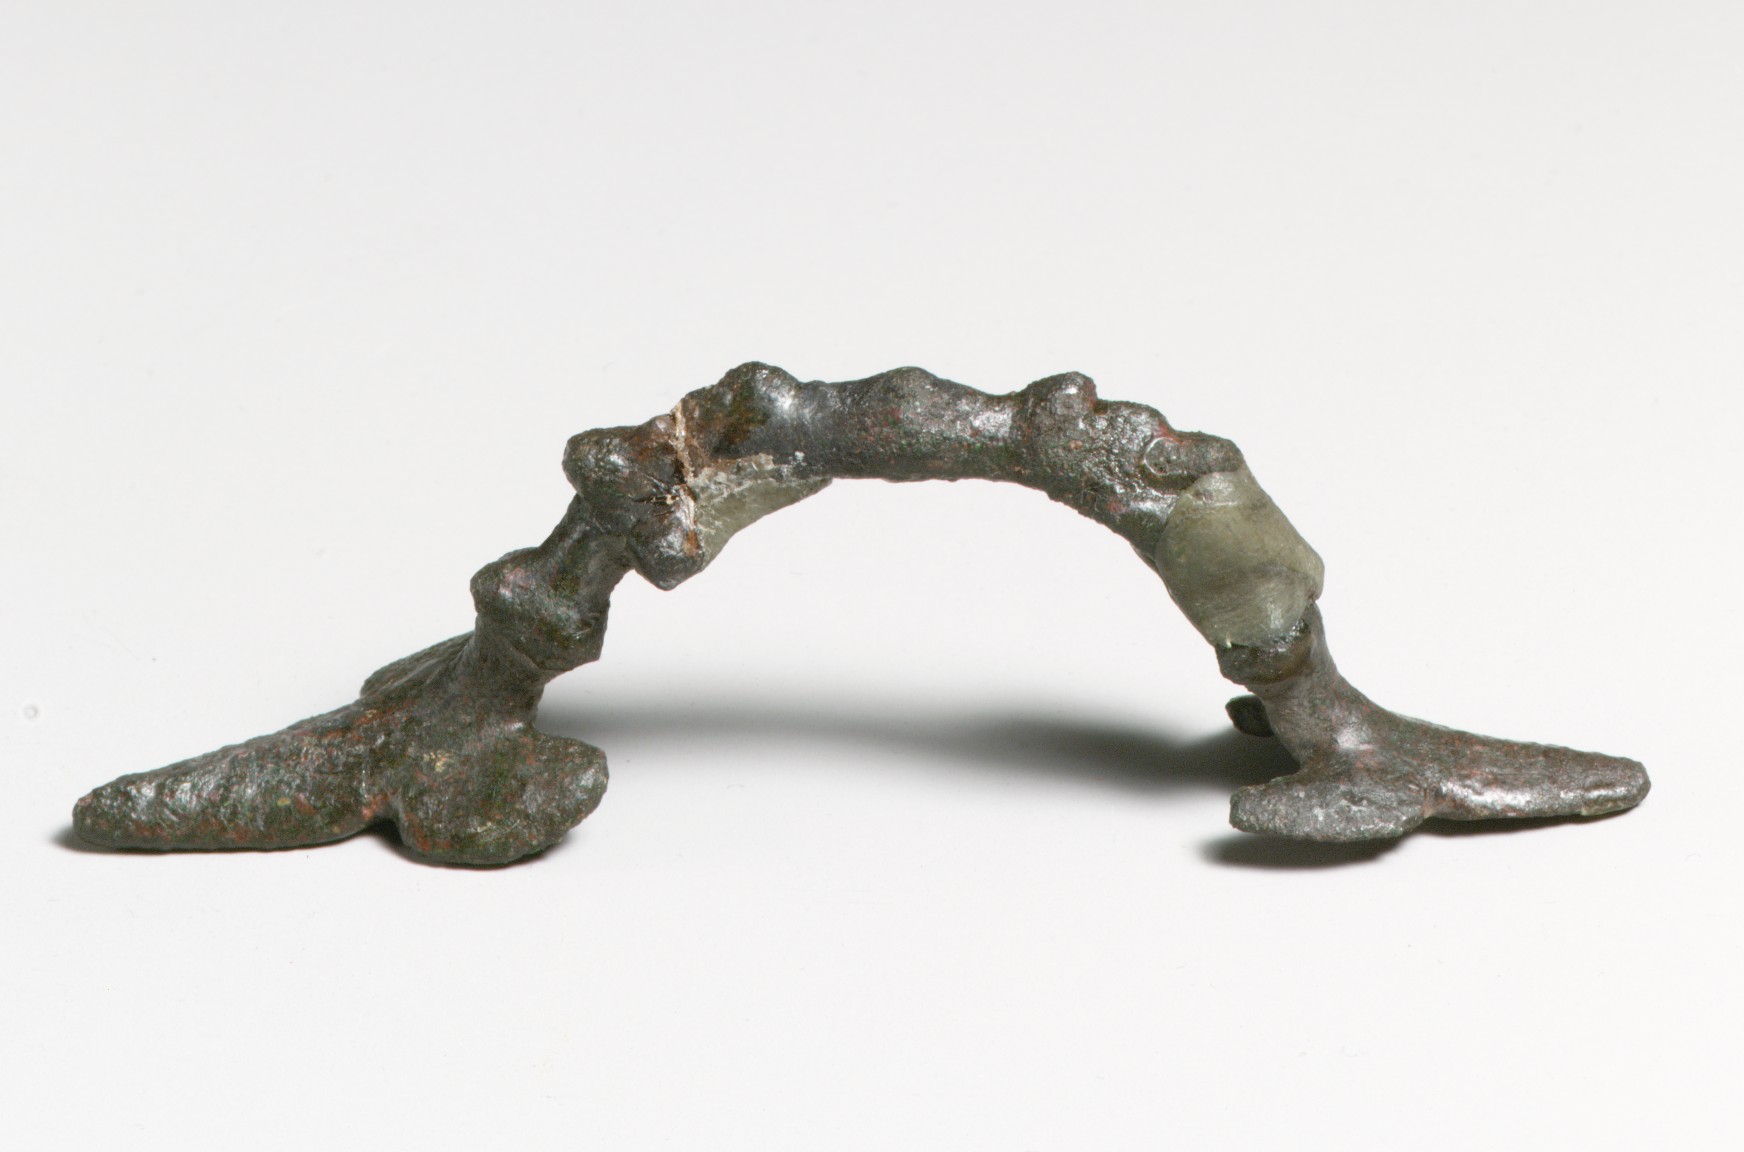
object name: handle of a bowl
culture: roman, cypriot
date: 50-400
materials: bronze